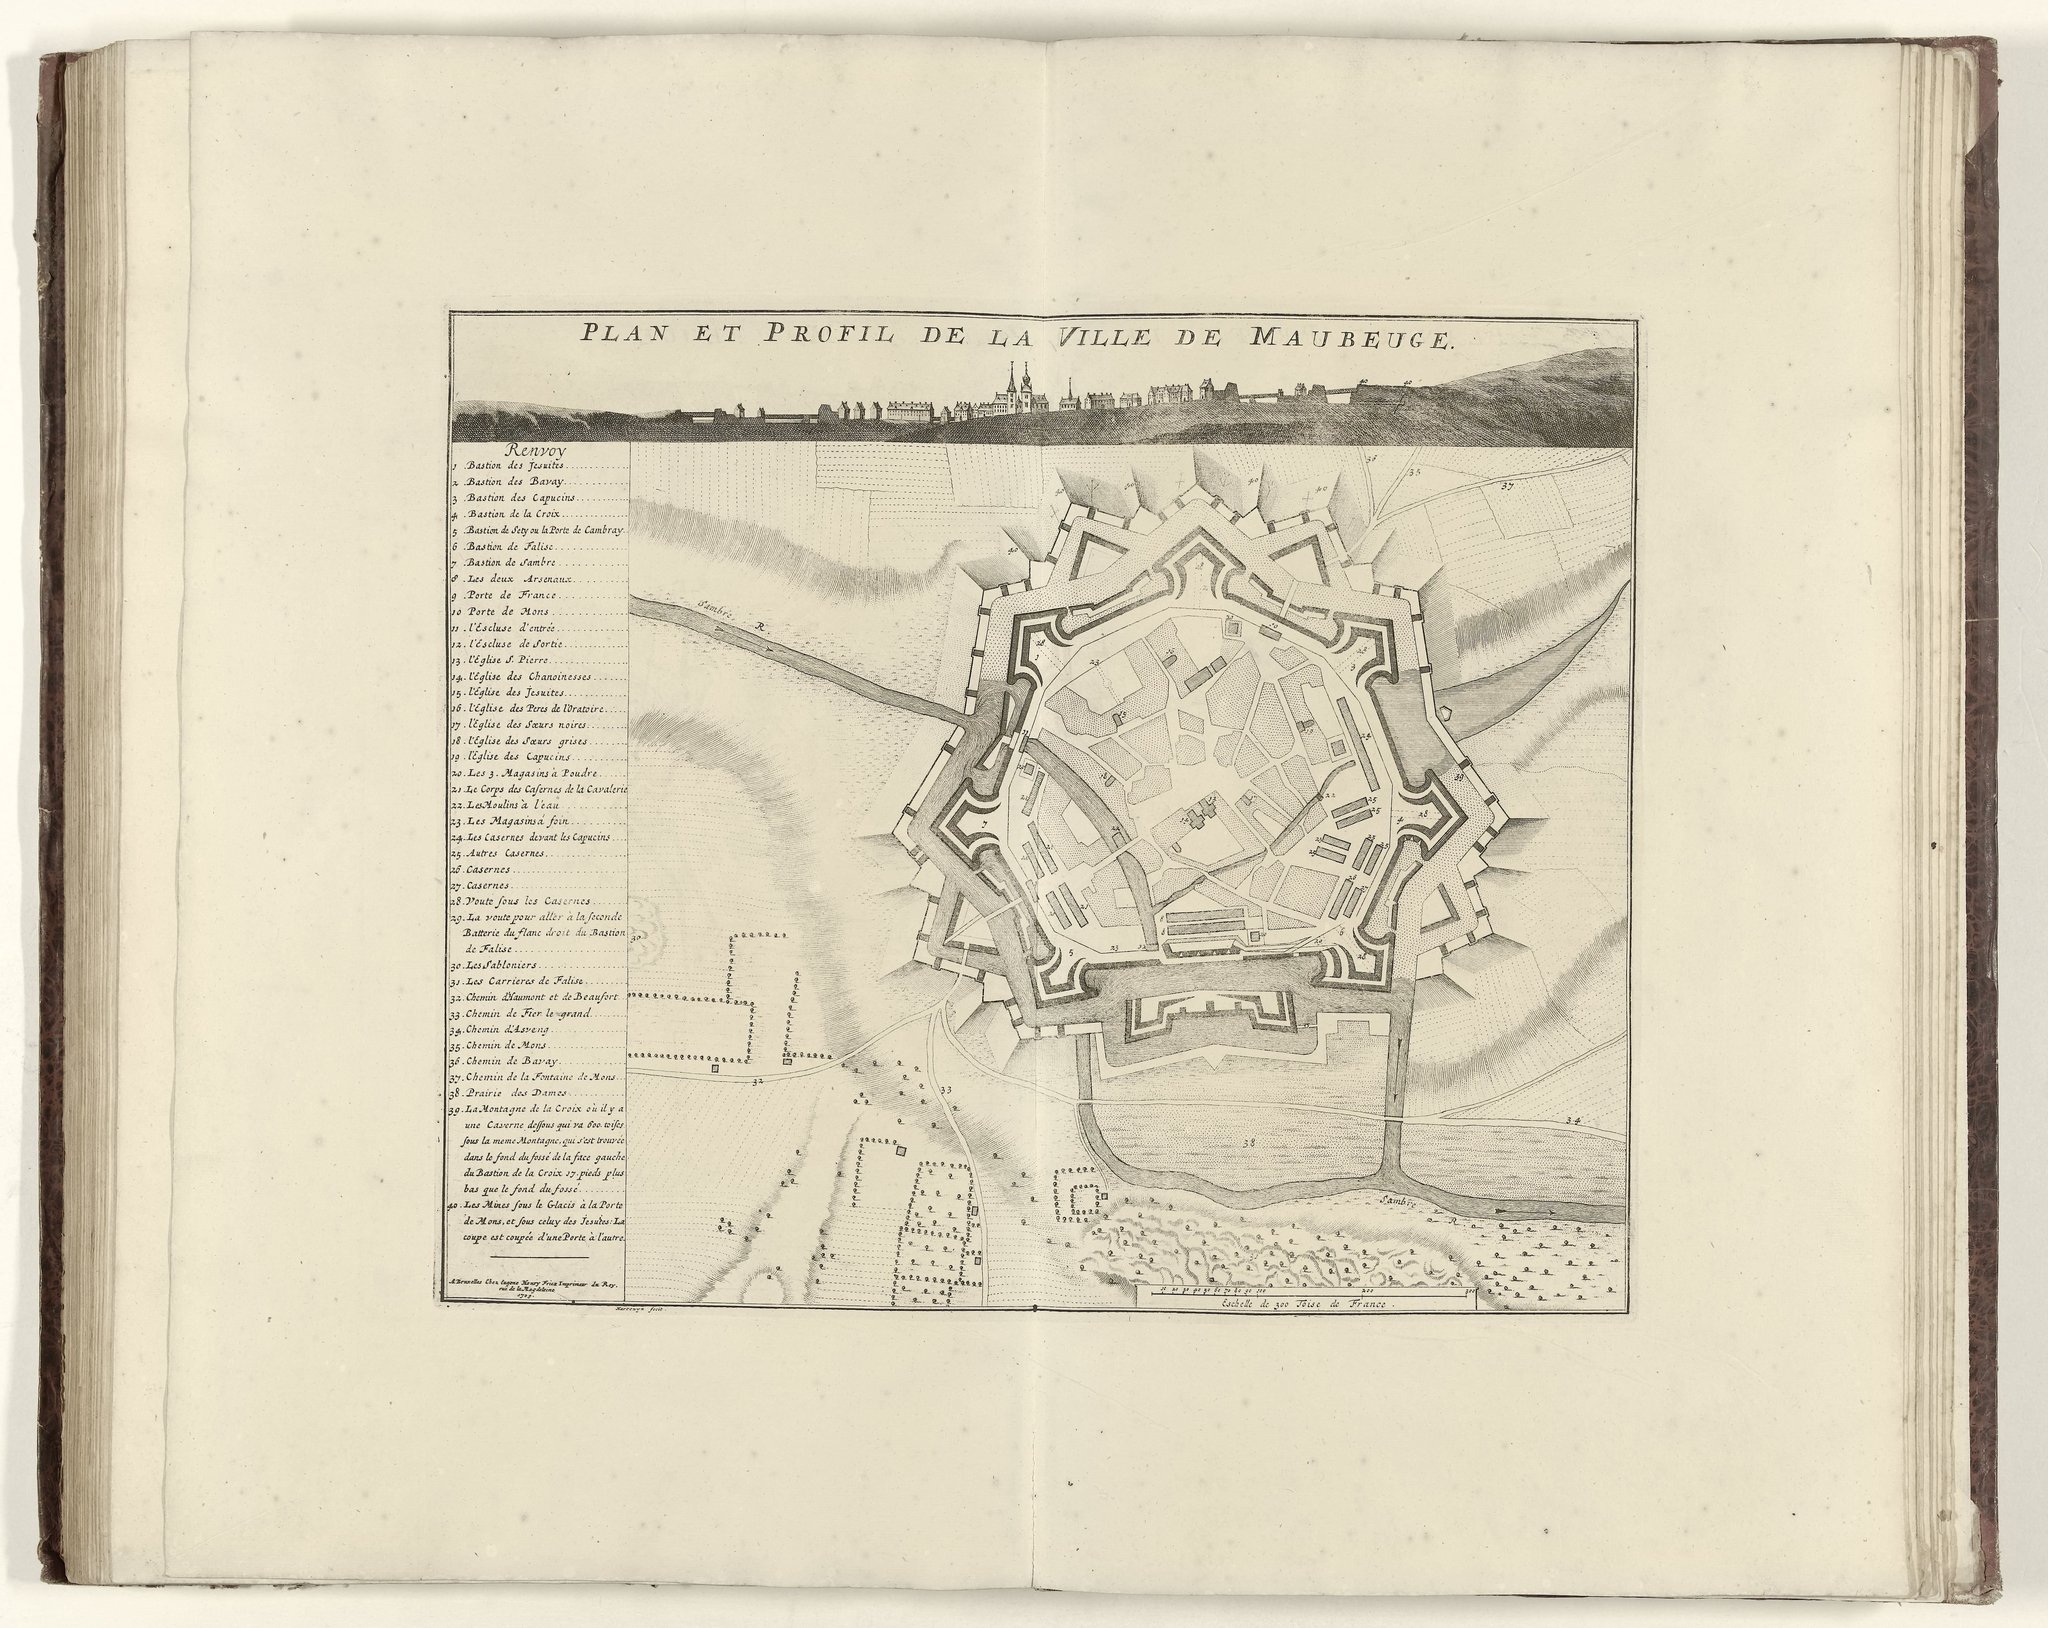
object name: map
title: Plattegrond van Maubeuge, 1709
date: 1709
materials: paper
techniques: etching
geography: brussels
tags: maps of cities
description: Plattegrond van Maubeuge, 1709. Bovenaan een profiel van de stad, aan de linkerkant de legenda 1-40. Onderdeel van een gebundelde verzameling van plannen van veldslagen en steden vermaard in de Spaanse Successieoorlog.